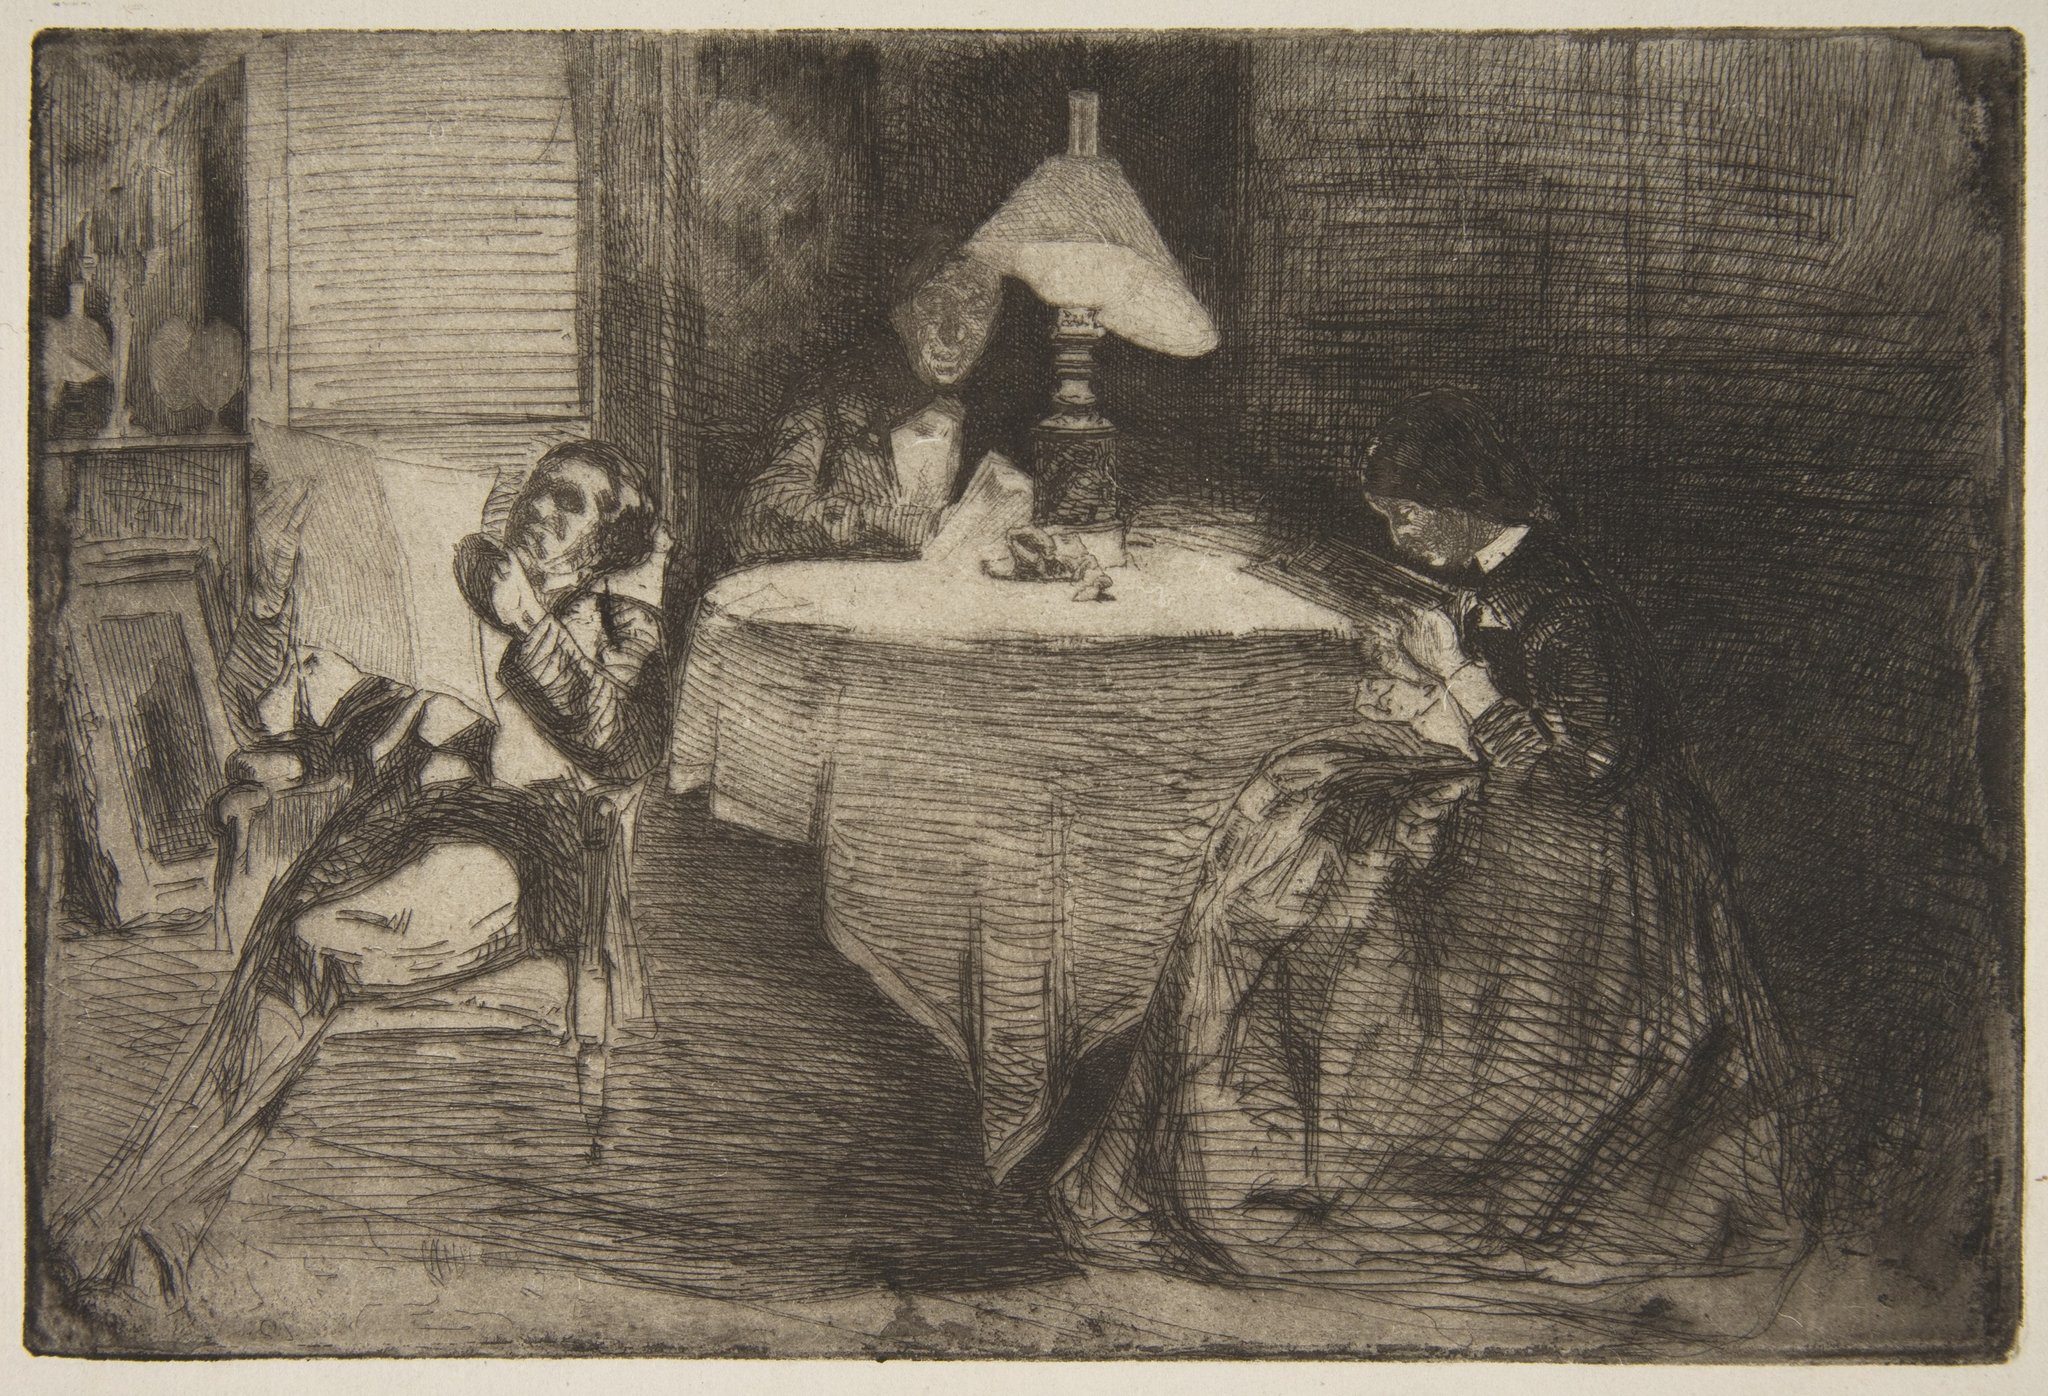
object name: print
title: The Music Room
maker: james mcneill whistler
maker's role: artist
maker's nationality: american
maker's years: 1834-1903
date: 1859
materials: ink, paper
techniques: casting, etching, printing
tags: men,women,reading